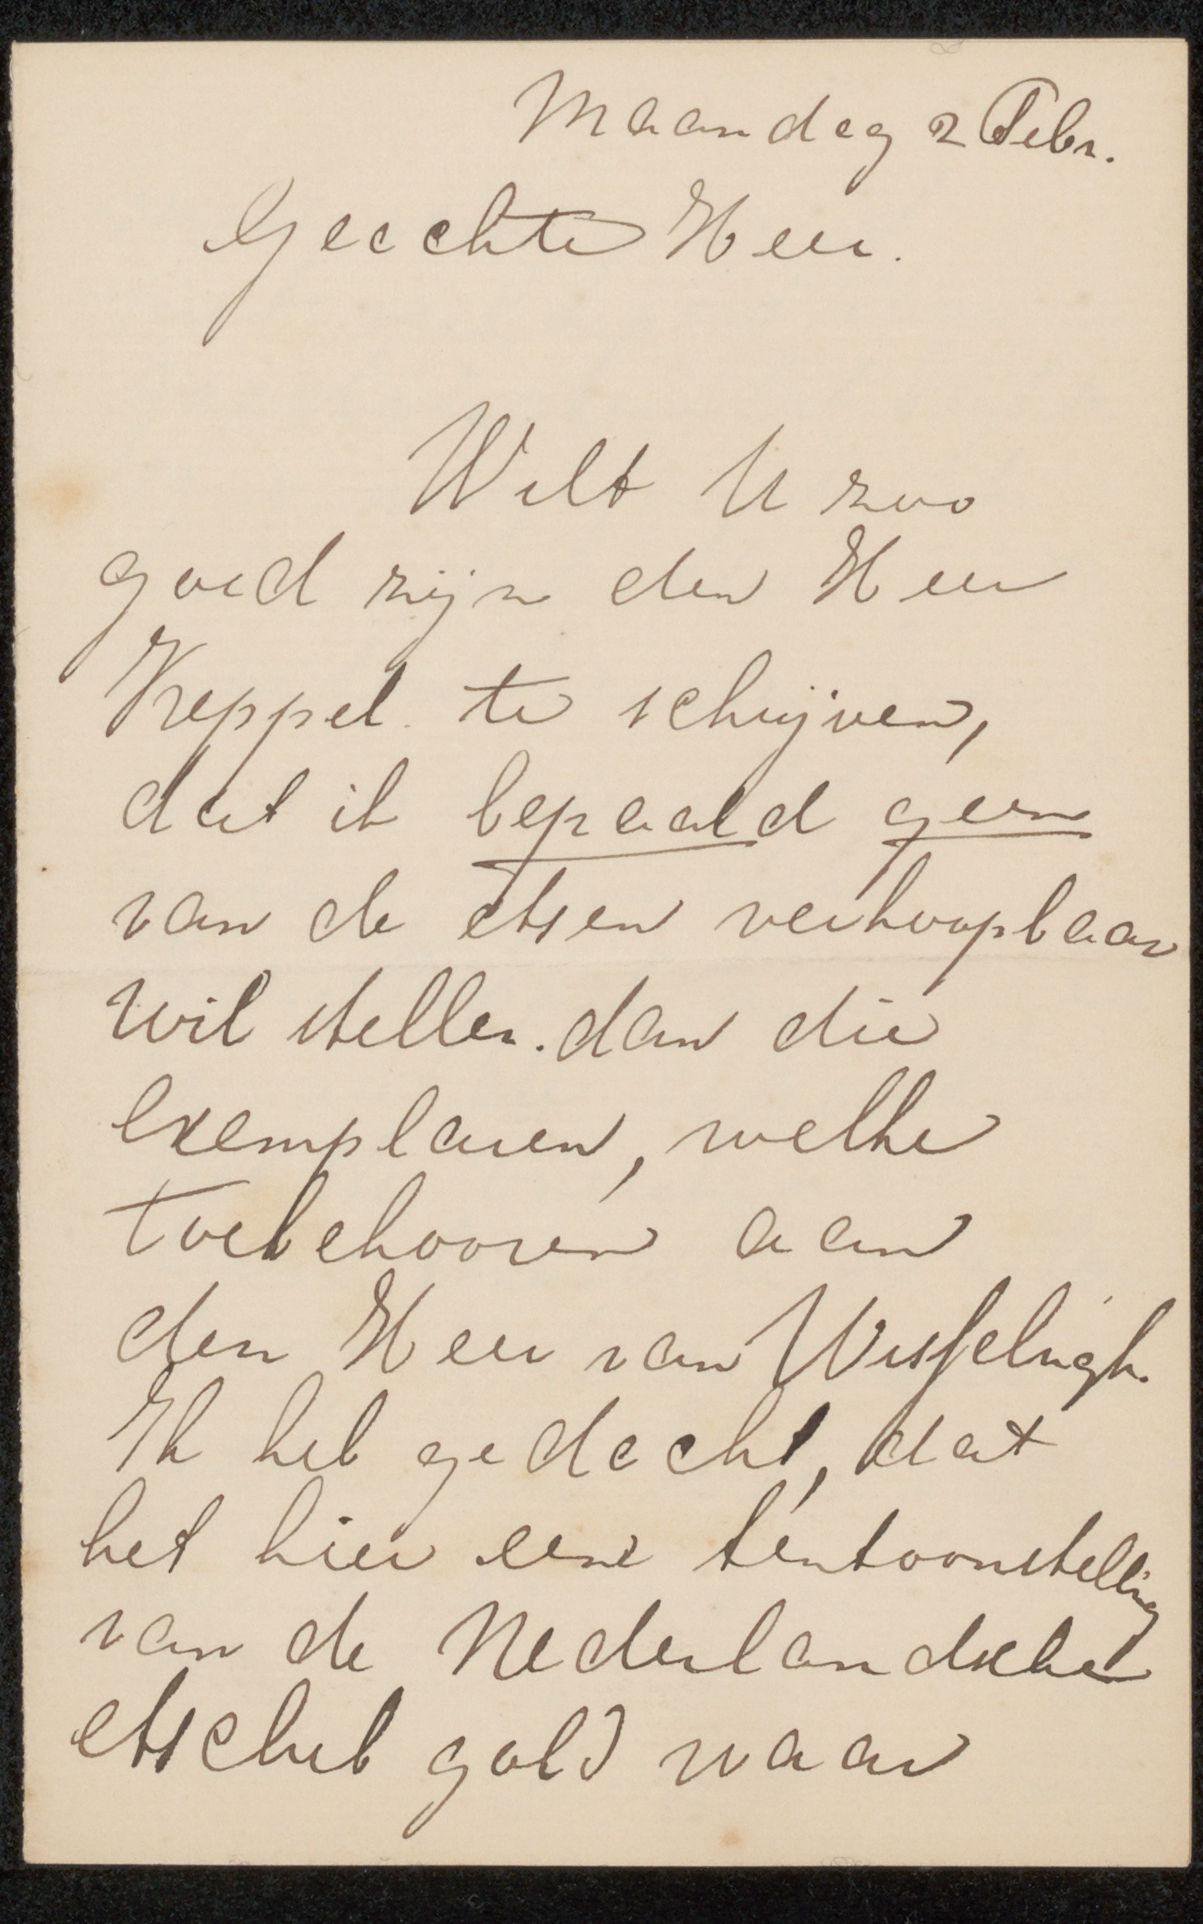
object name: letter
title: Brief aan Philip Zilcken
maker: barbara elisabeth van houten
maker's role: draughtsman, print maker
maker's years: 1862-1950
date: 1872-1930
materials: ink, paper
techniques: pen, writing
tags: frederick keppel, elbert jan van wisselingh, the hague, painter, philip zilcken, art trade, art shop, the graphic arts, temporary exhibition, 'salon'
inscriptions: collector's mark: ‘RPK’